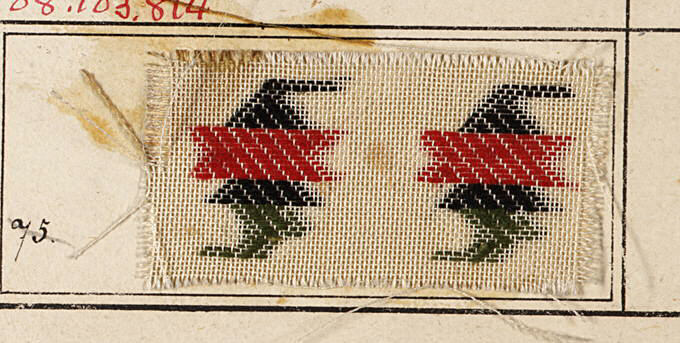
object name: ribbon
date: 1701-1900